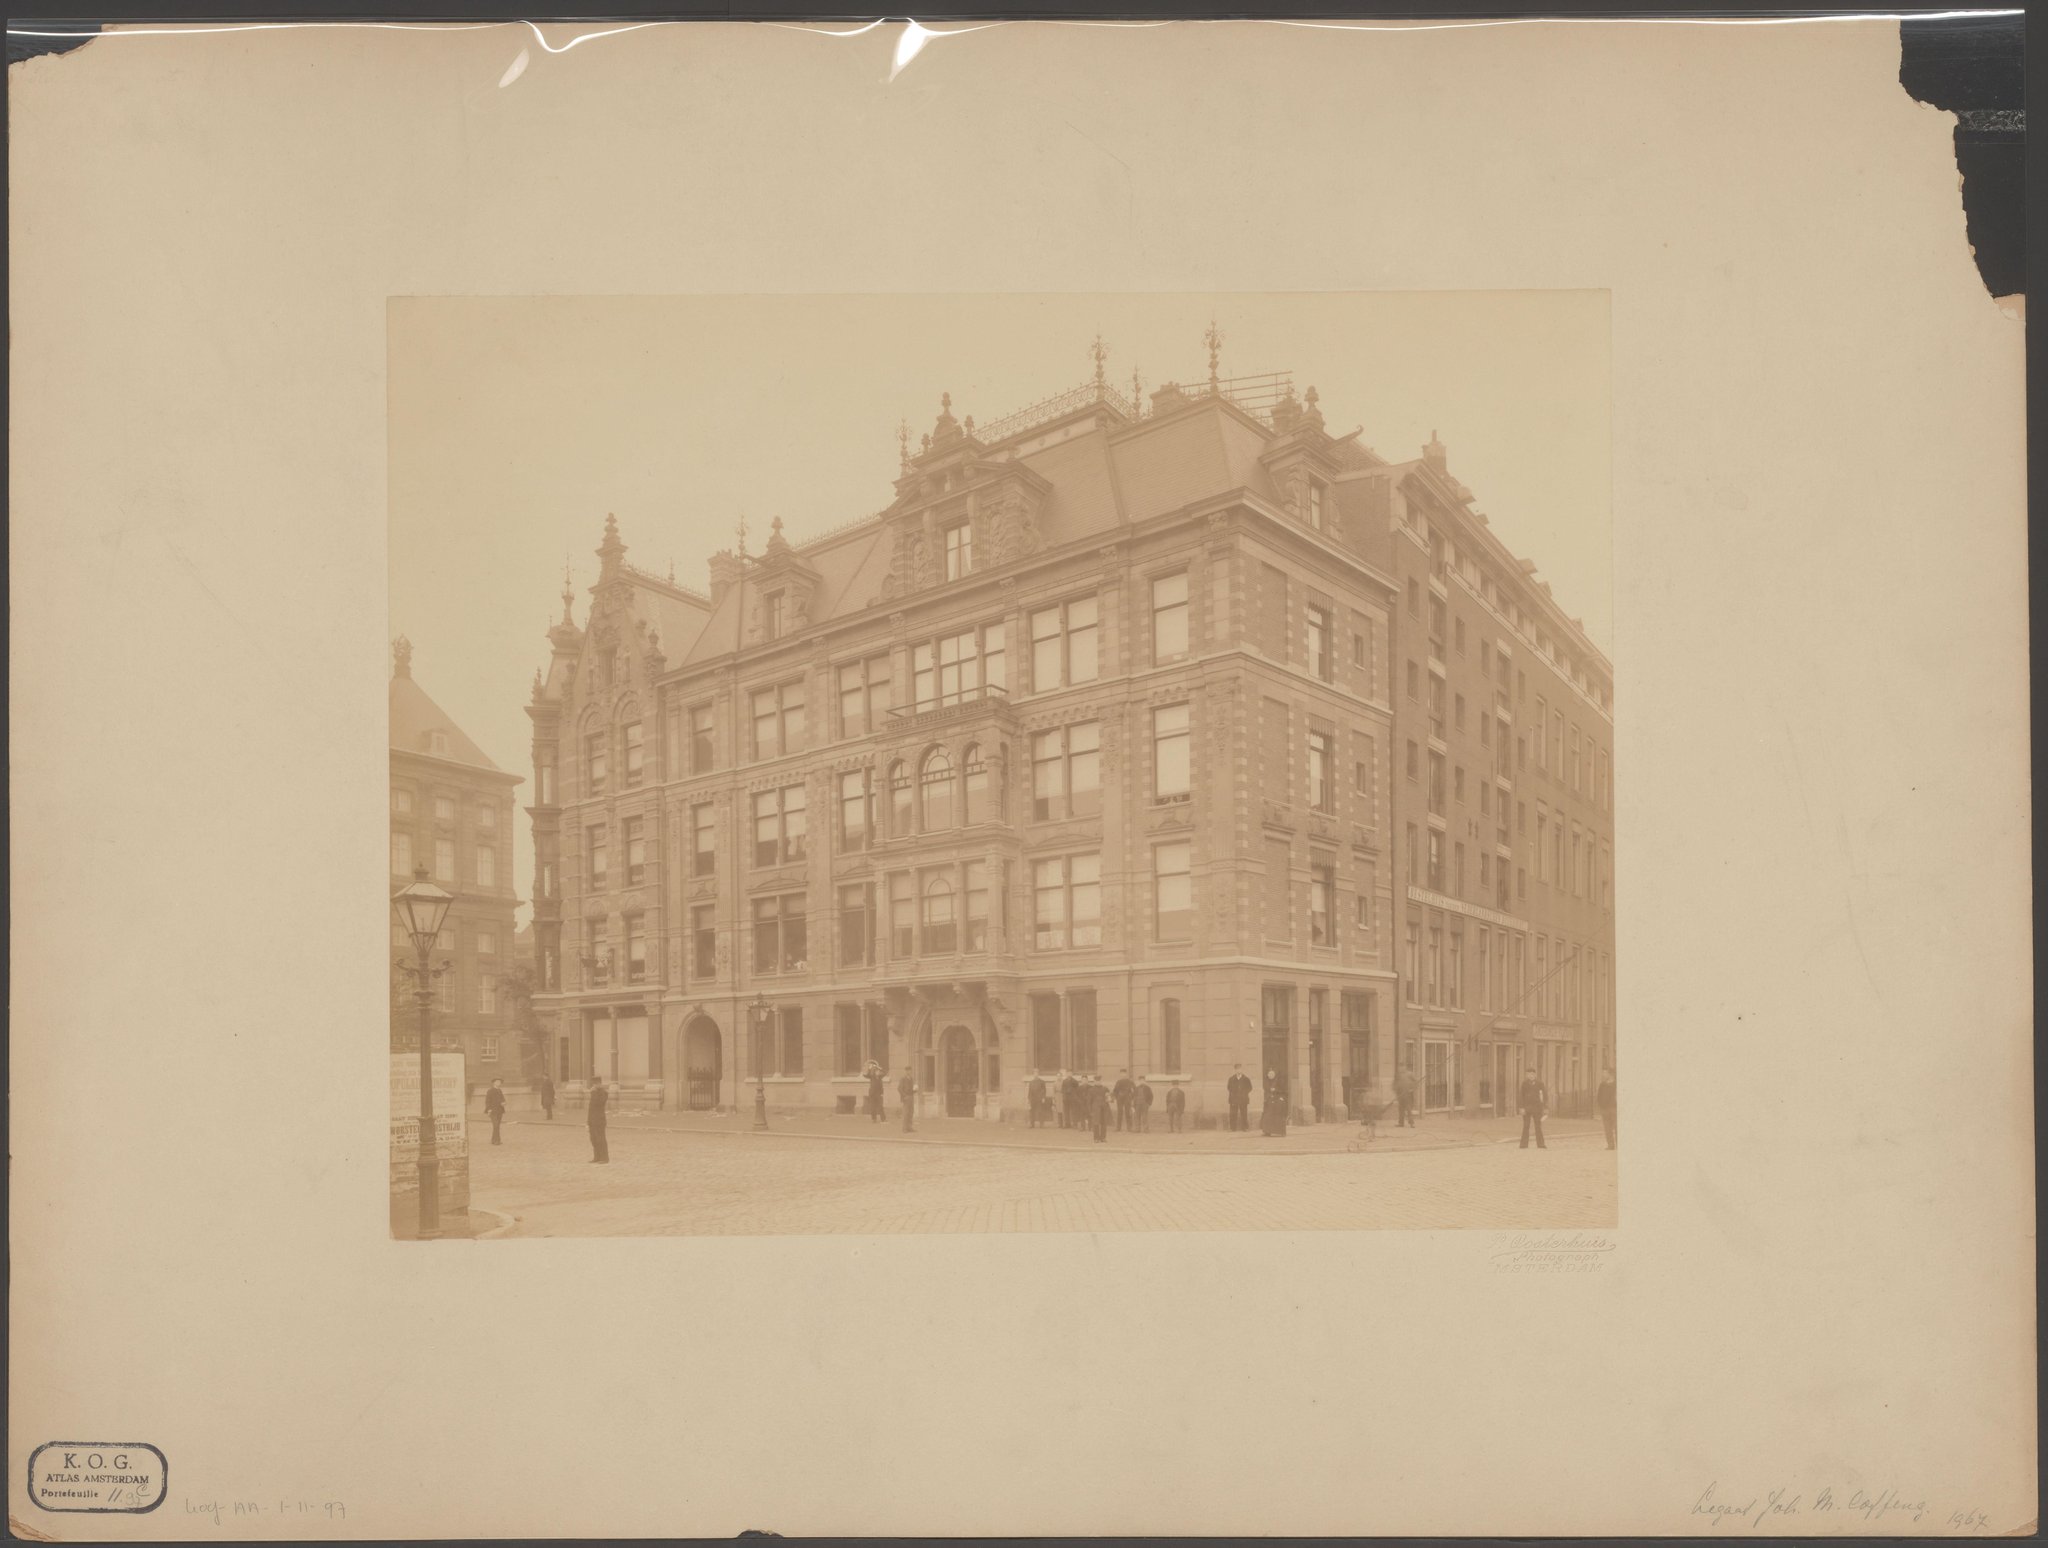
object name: photograph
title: Gezicht op het Rijkskantoorgebouw voor het Geld- en Telefoonbedrijf aan de Raadhuisstraat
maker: pieter oosterhuis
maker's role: draughtsman, print maker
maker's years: 1816-1885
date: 1831-1885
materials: cardboard, paper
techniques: albumen print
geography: amsterdam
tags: city-view in general; 'veduta', façade (of house or building), office (~ administration), street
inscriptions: collector's mark: ‘11.97C’ Lugt 1641b, inscription: ‘Legaat Joh. M. Coffeng. 1967’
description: Onderwerpsrubriek binnen de Atlas Amsterdam: Raadhuisstraat, Raamgracht, Raamplein, Rapenburgerstraat, Reguliersgracht, Reguliersbreestraat.